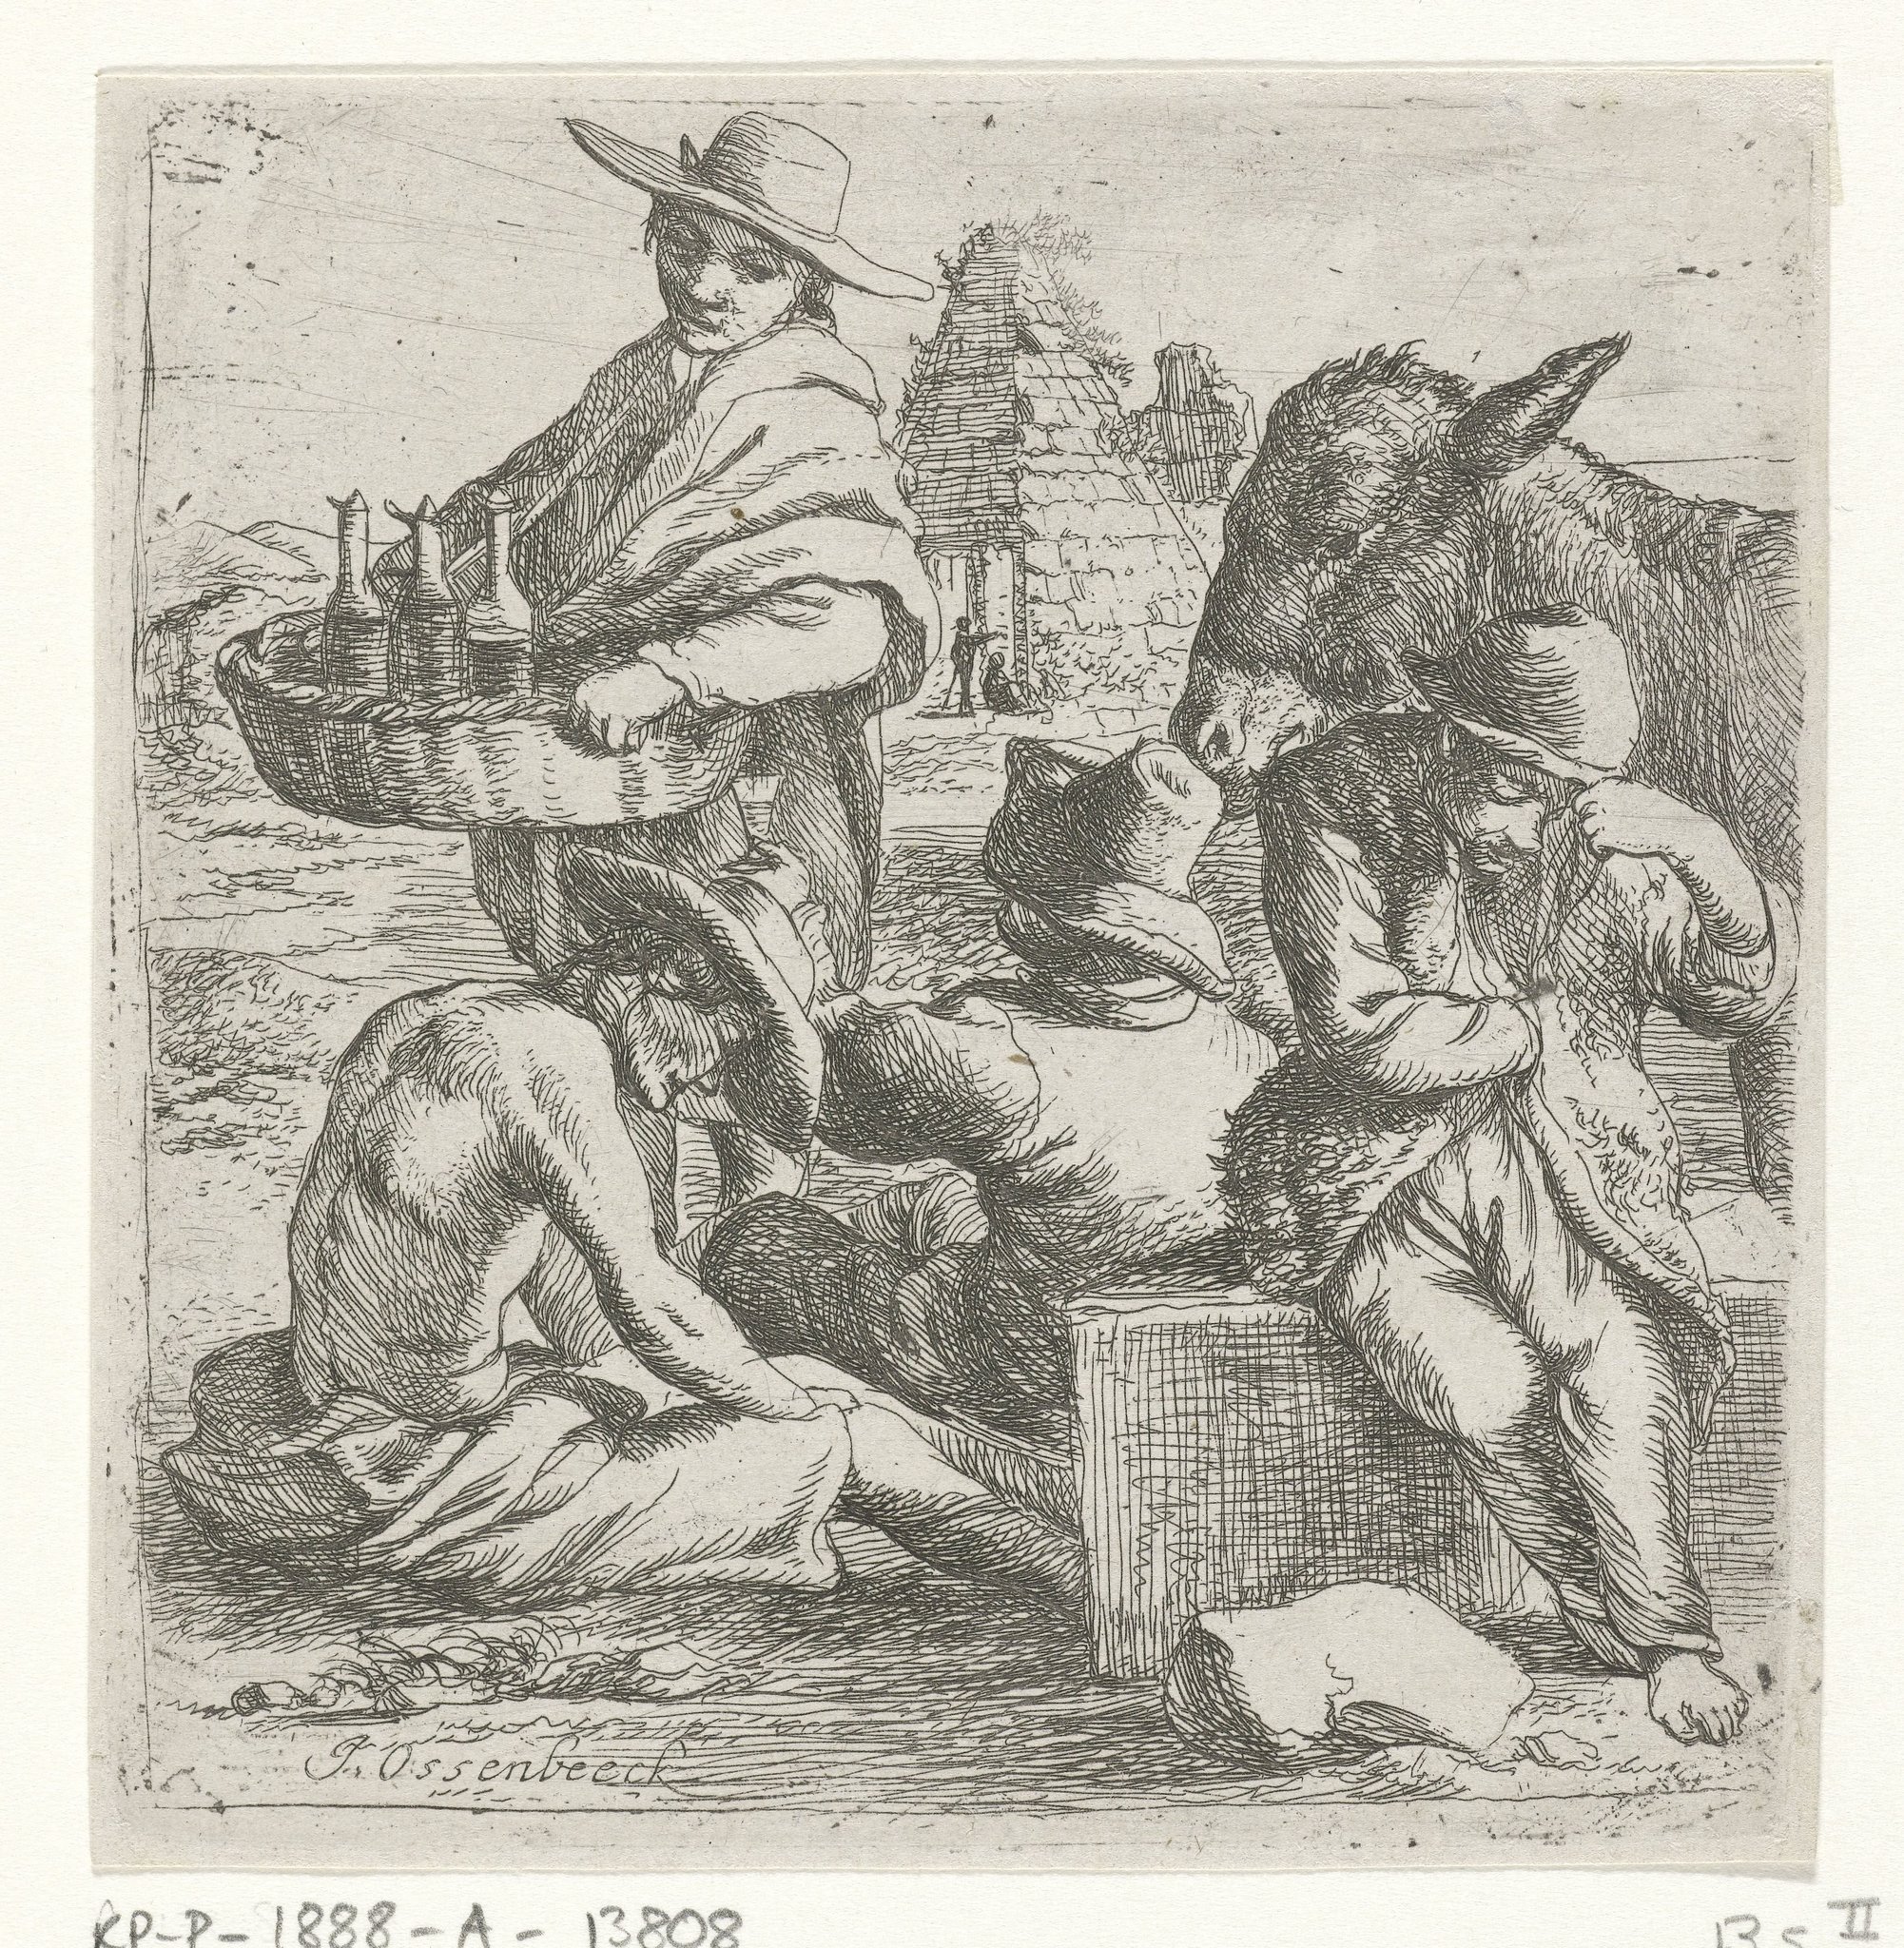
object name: print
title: De jeneververkoper en de drie bedelaars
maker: jan van ossenbeeck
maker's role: print maker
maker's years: 1623-1674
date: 1647-1674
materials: paper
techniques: etching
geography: netherlands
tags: genever, gin, wandering or travelling merchant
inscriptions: collector's mark: Lugt 2228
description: Langs een weg zitten drie bedelaars met hun ezel bij een stenen blok. Een van hen zit op de steen. Een koopman die een mand met flessen voor zijn buik draagt komt langs om zijn jenever te verkopen.